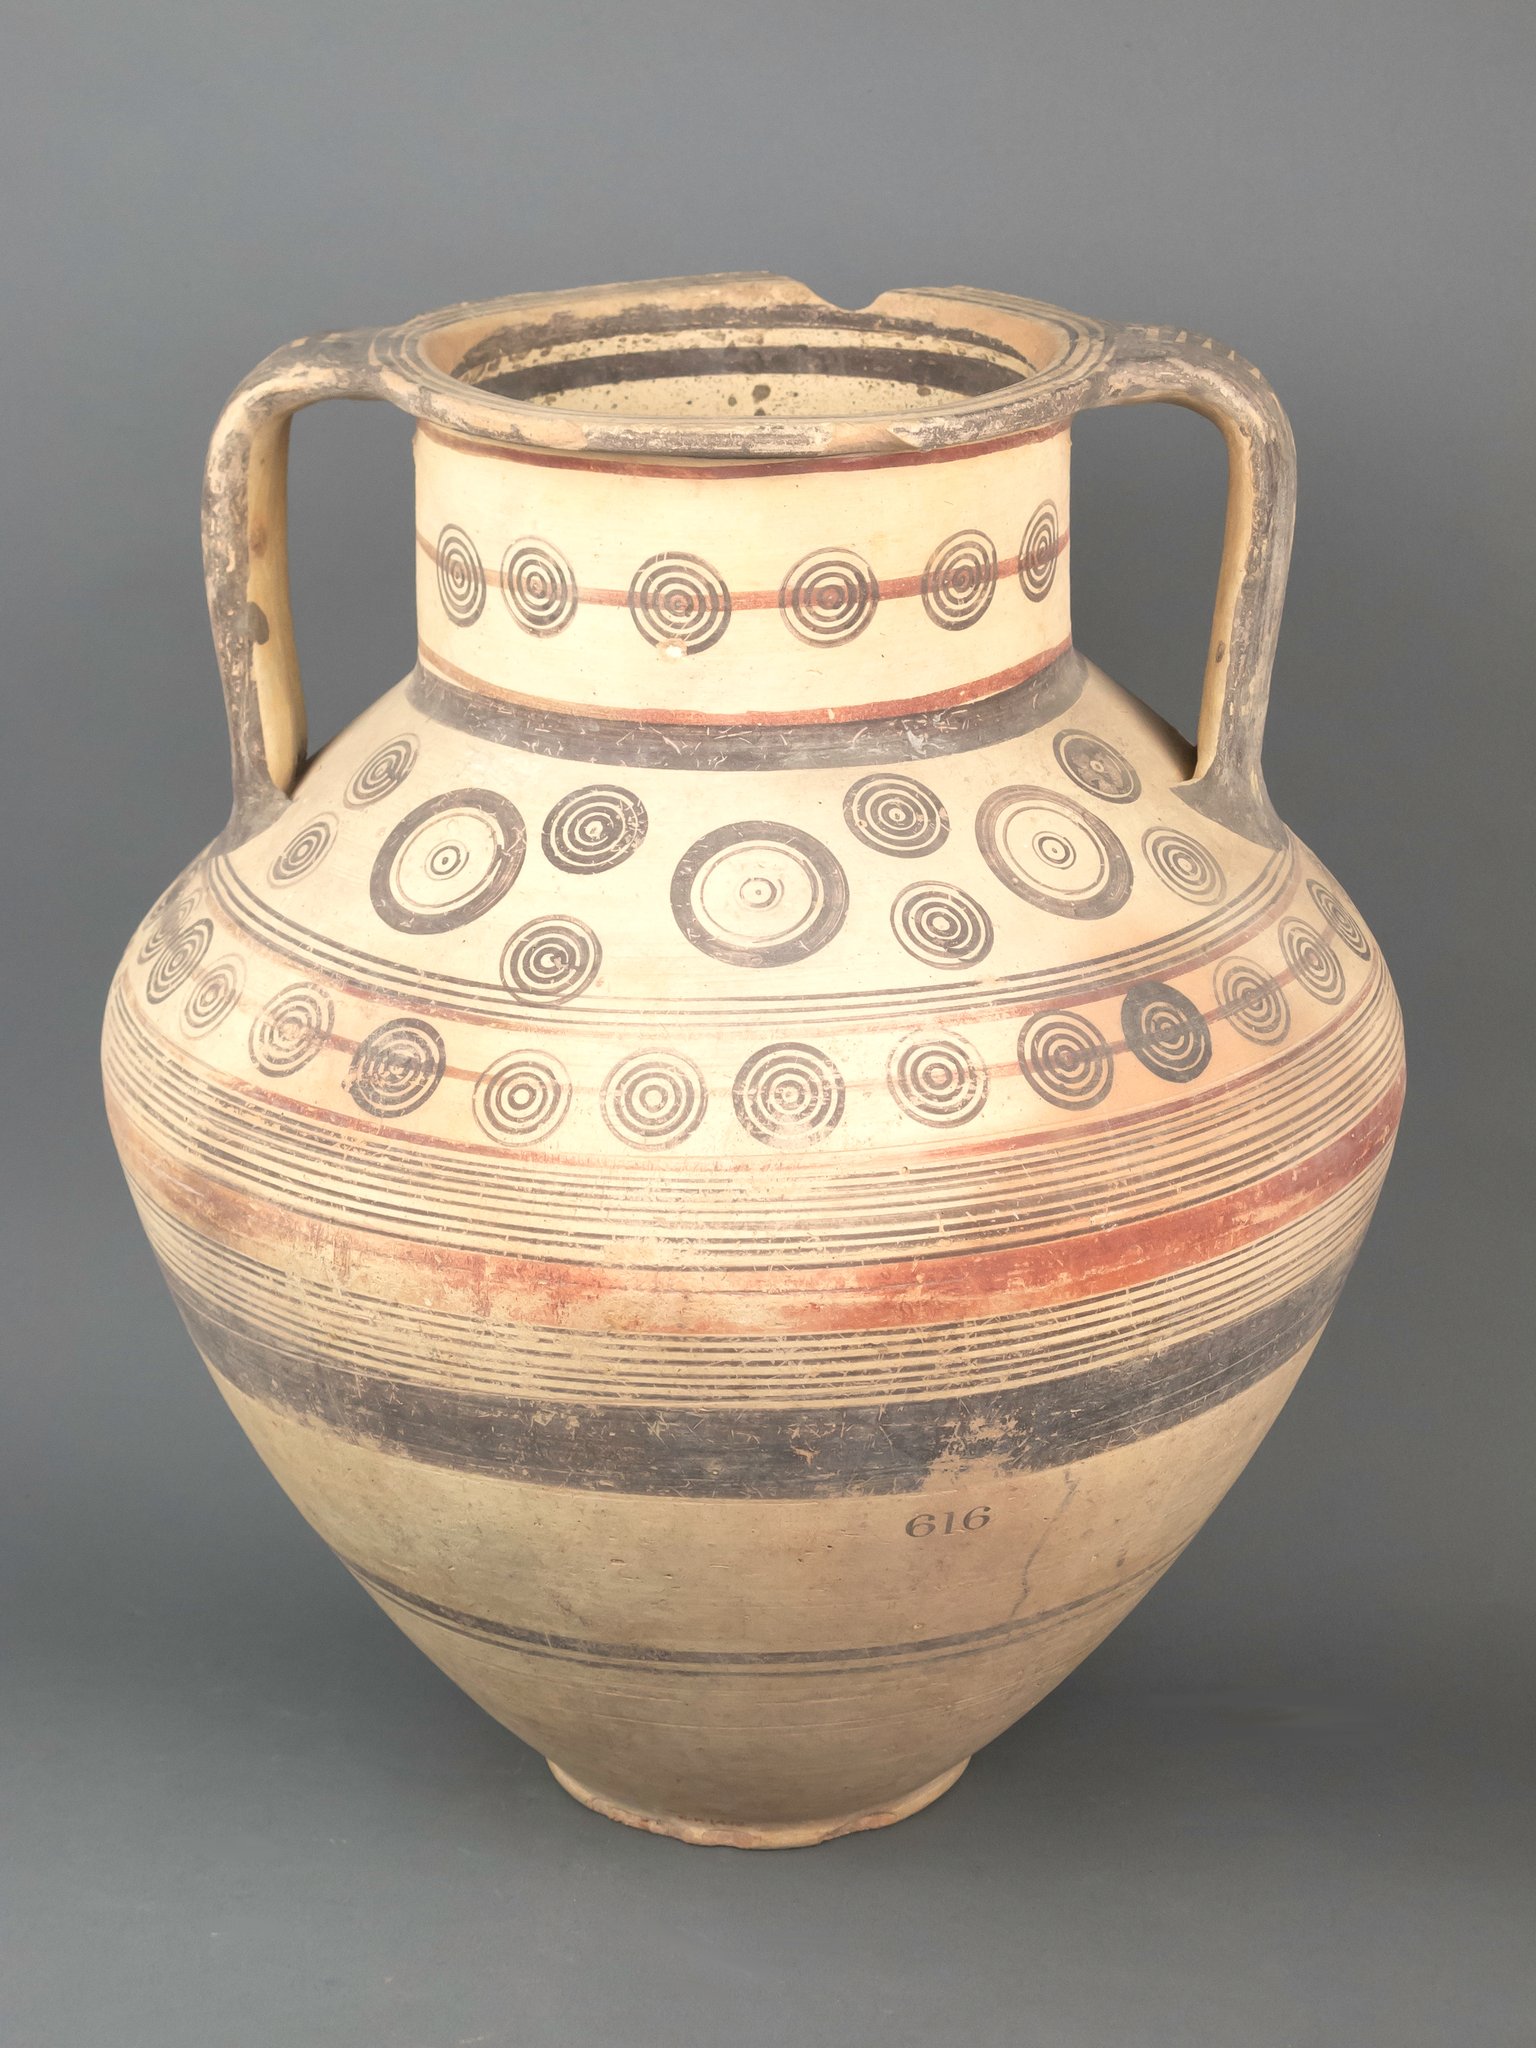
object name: amphora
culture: cypriot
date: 1050-900 BCE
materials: terracotta